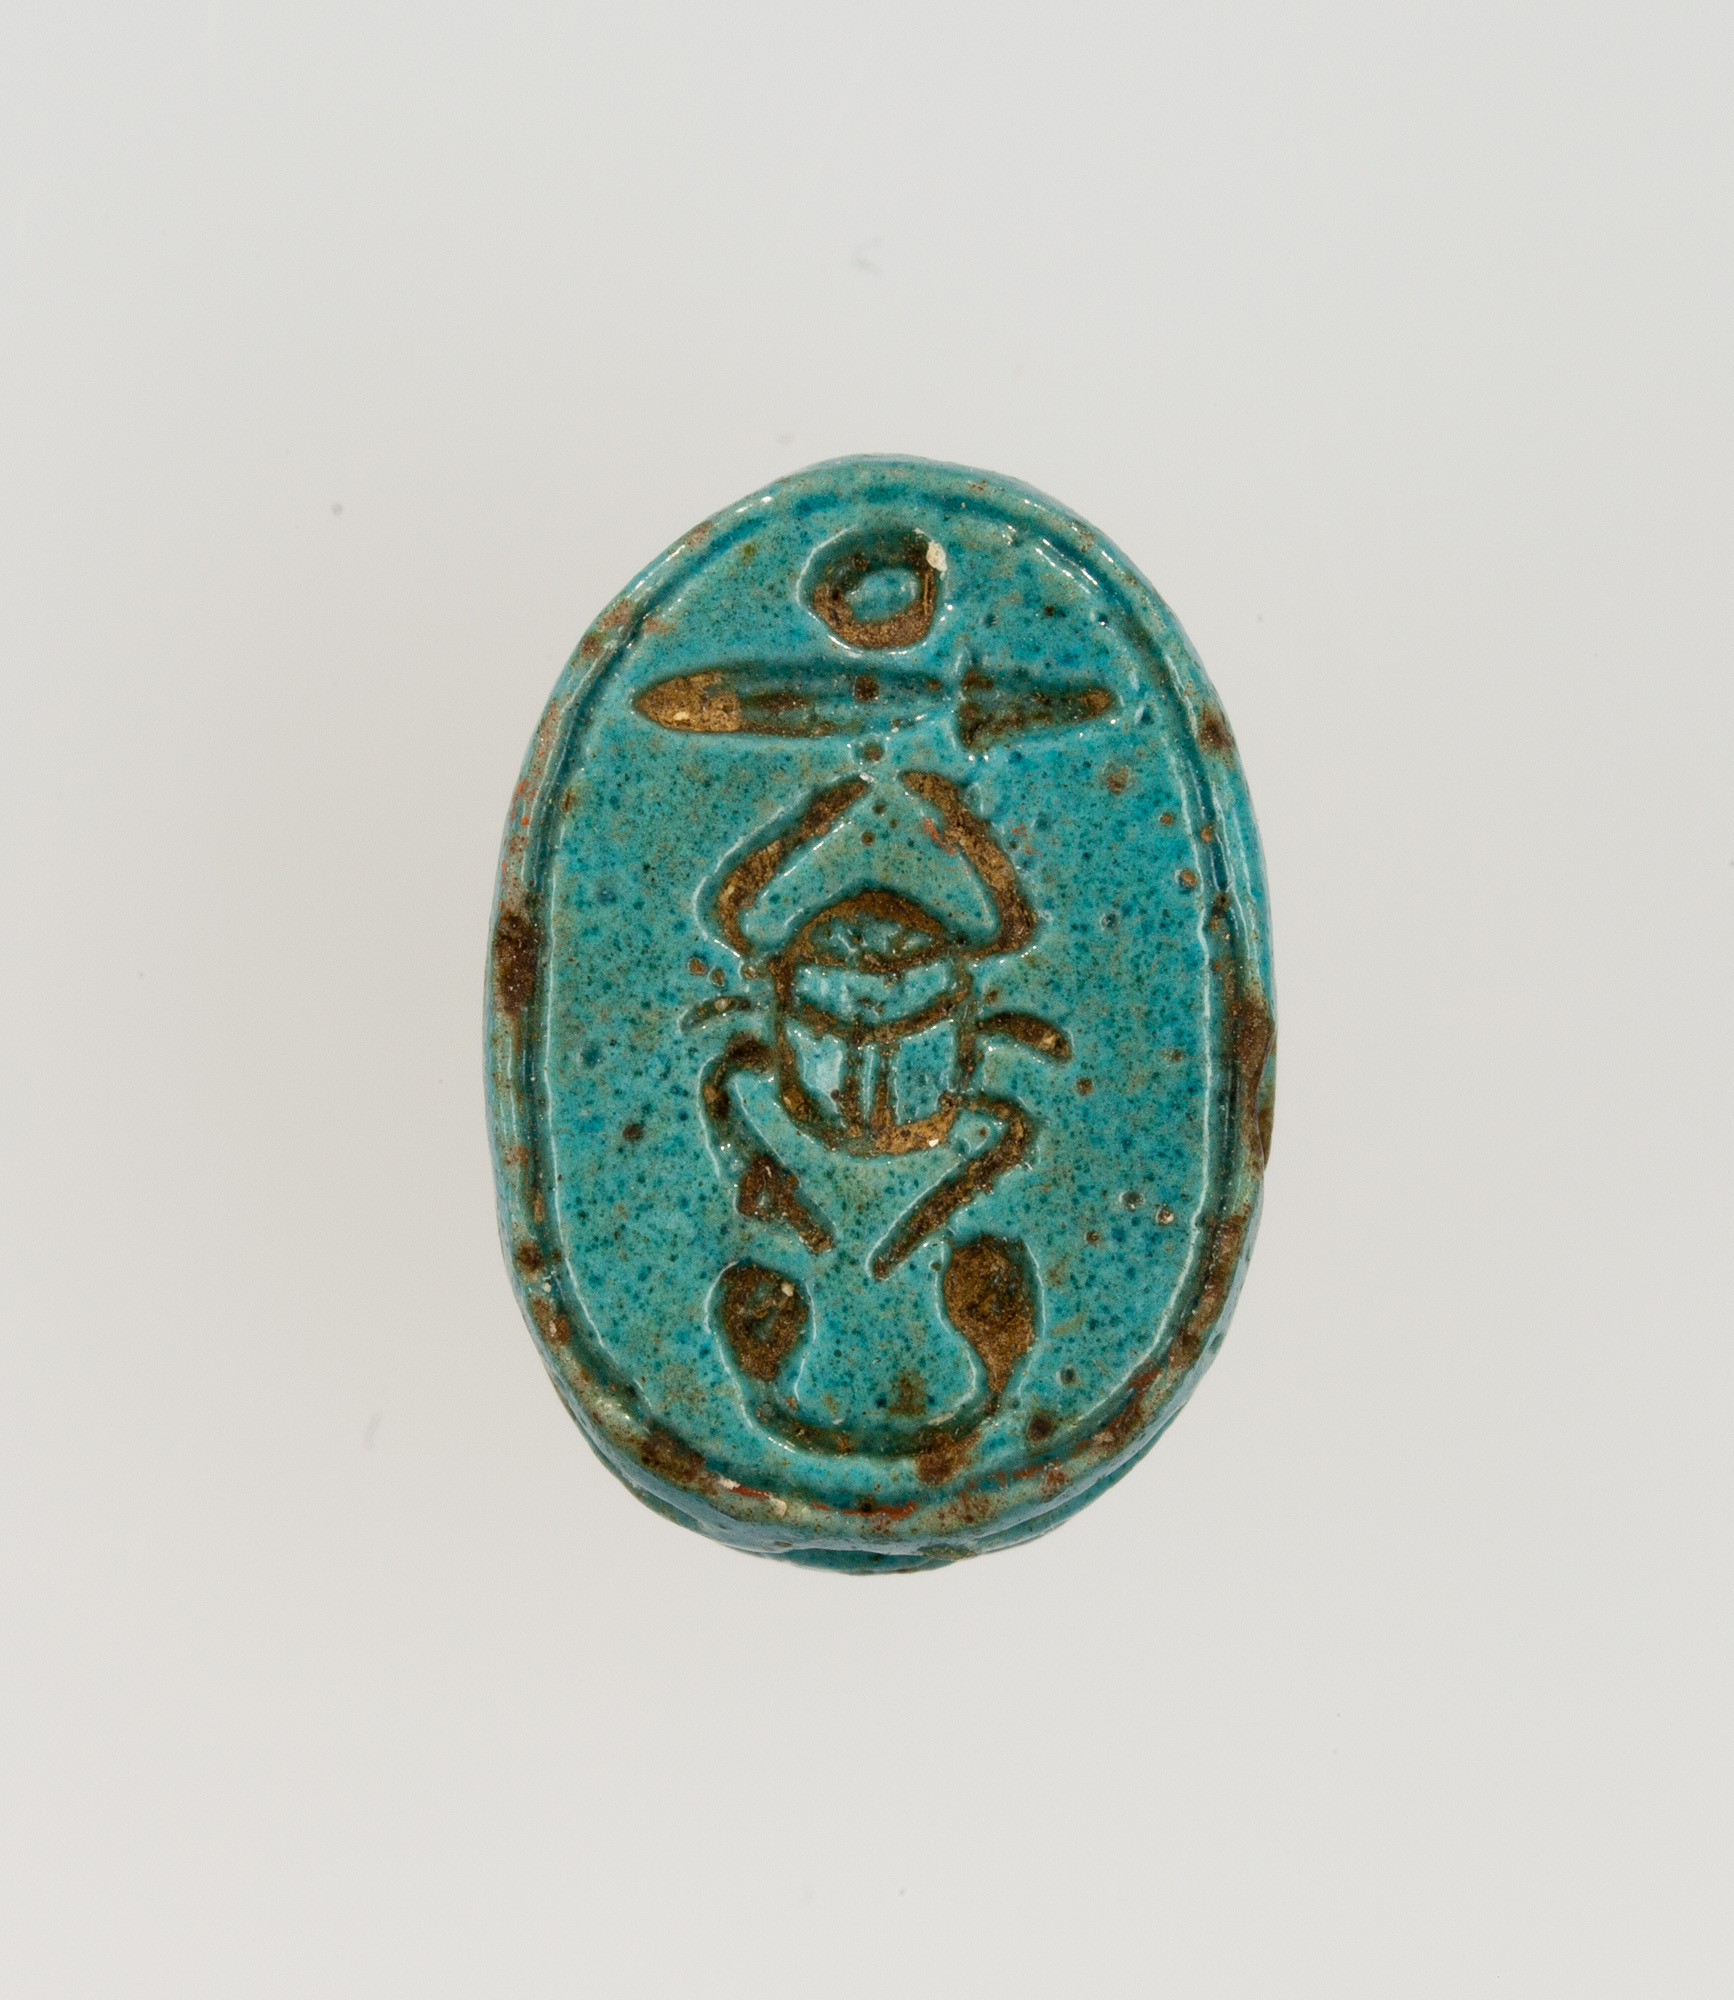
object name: scarab, thutmose i, aakheperkare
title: Scarab Inscribed with the Throne Name of Thutmose I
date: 1504-1492 BCE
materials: stone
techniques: glazing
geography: egypt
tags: scarabs